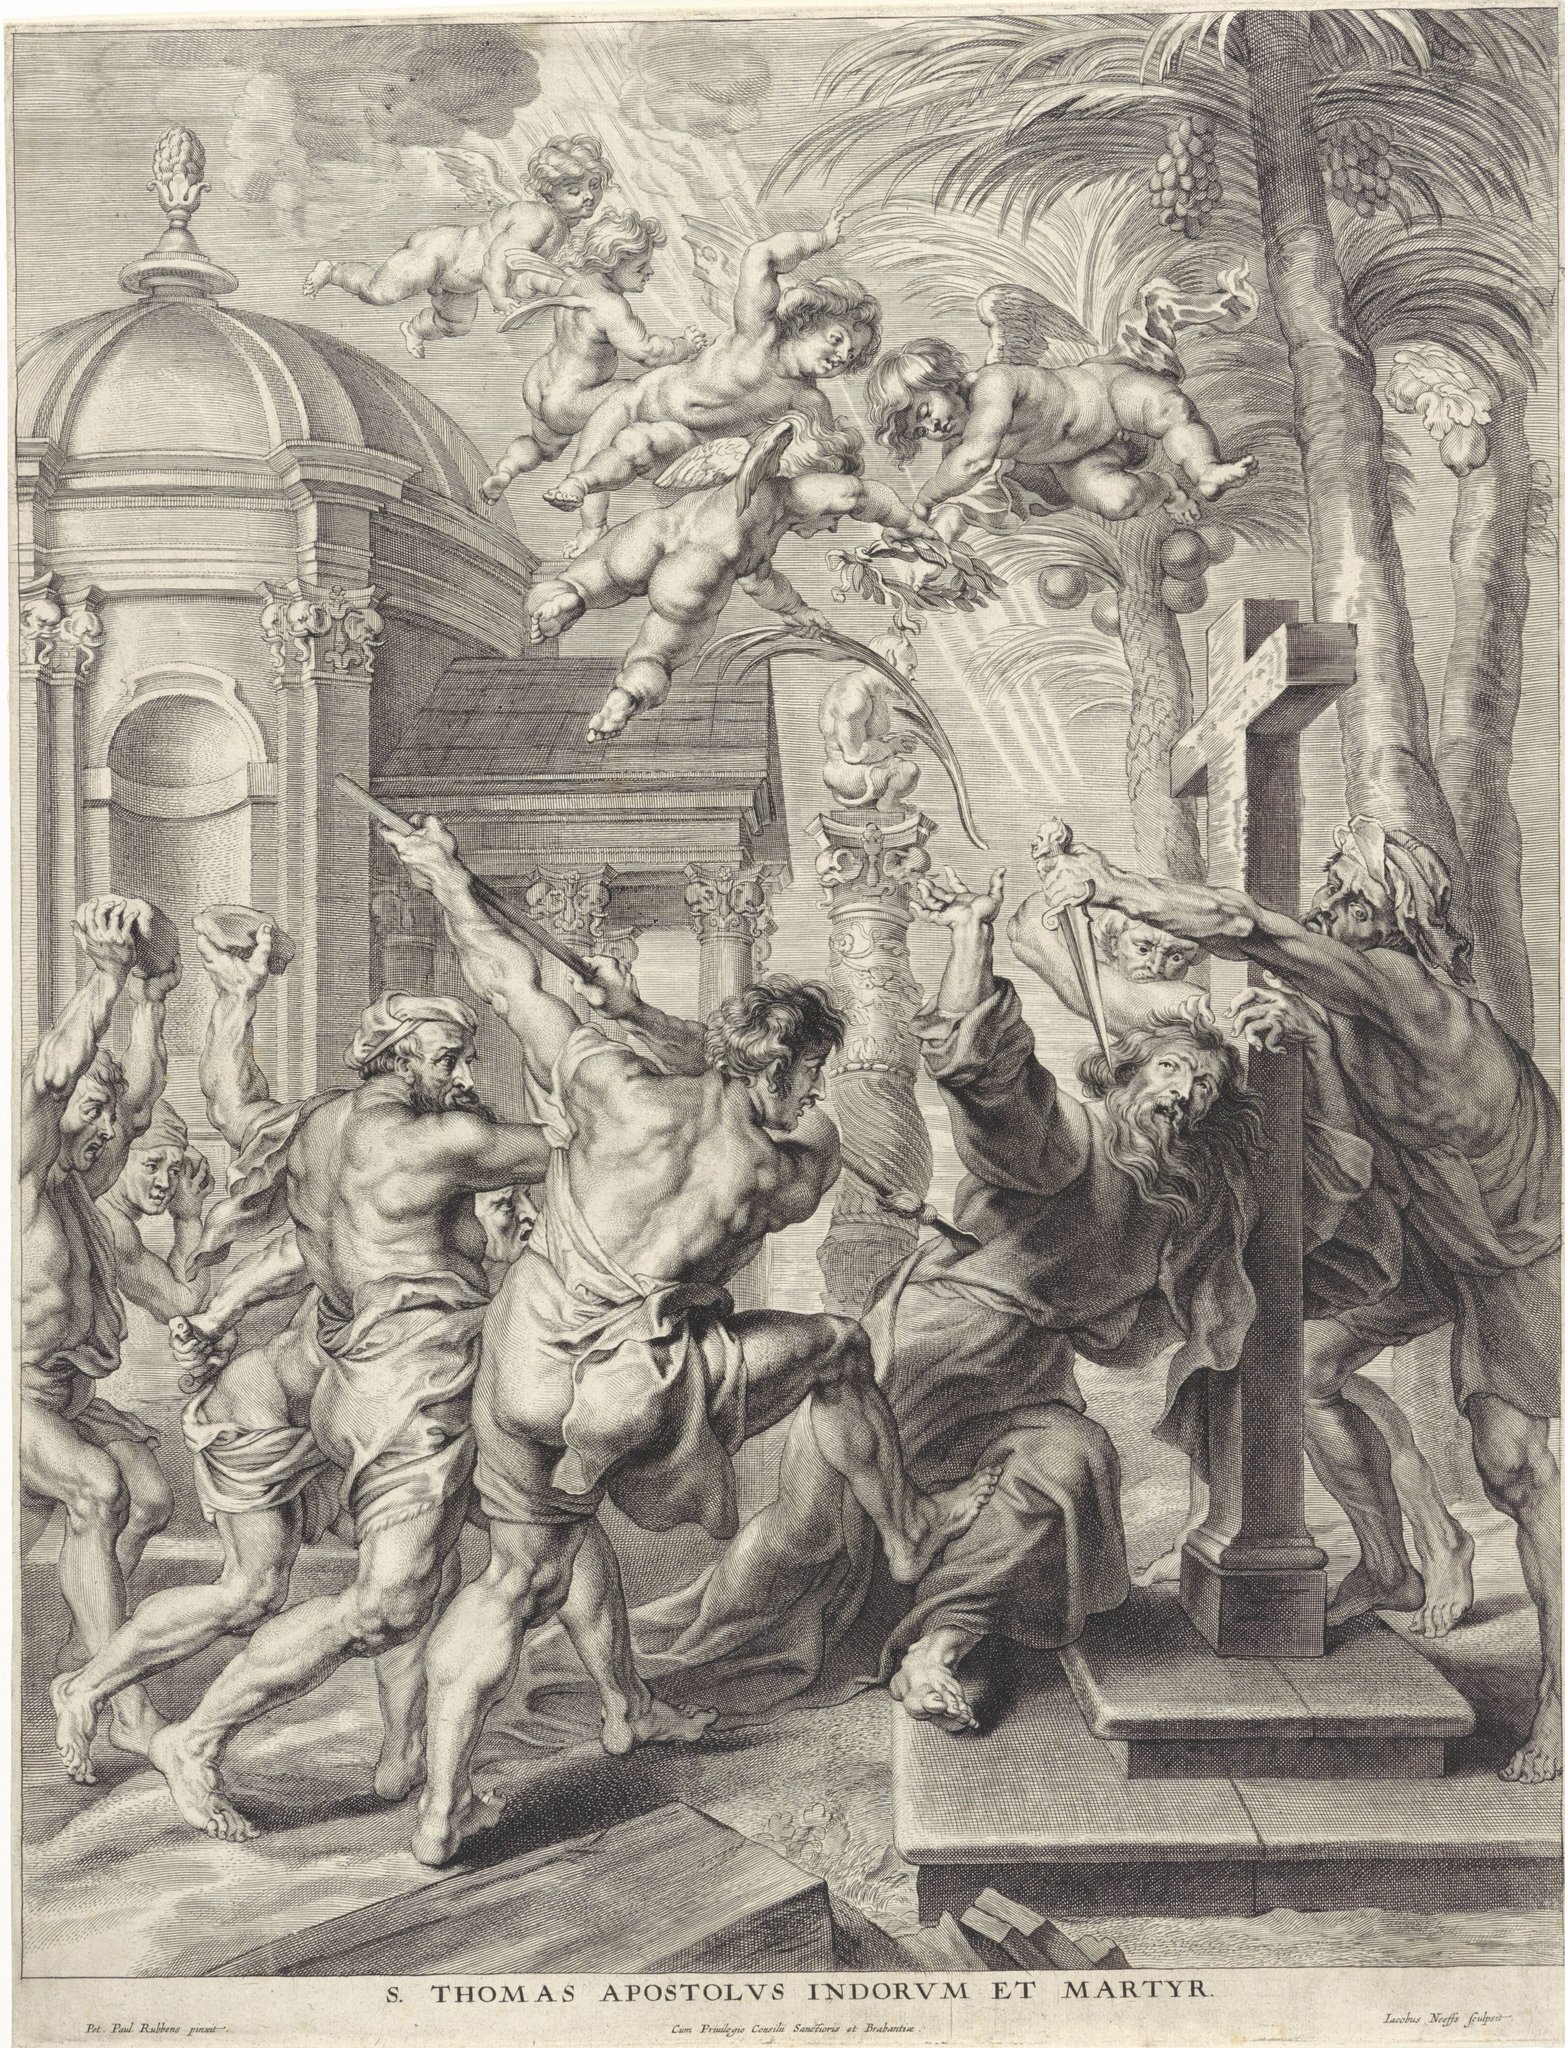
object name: print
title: Marteldood van de apostel Tomas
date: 1620-1680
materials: paper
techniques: engraving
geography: antwerp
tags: places and objects of worship ~ hinduism, buddhism, jainism, death of thomas: he is brought out of the city by four soldiers, who kill him with their lances, the apostle thomas; possible attributes: book, chalice, girdle, heart, lance or spear, scroll, square, stones - martyrdom, suffering, misfortune, death of male saint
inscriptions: collector's mark: Lugt 240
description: De apostel Tomas omhelst het kruis, terwijl hij door een man wordt doorstoken met een speer en een ander een dolk in zijn nek tracht te steken. Links tillen mannen stenen om Tomas te stenigen. Op de achtergrond staan palmbomen en een Indische tempel met een godenbeeld op een zuil. In de lucht vliegen putti met een palmtak en een lauwerkrans.